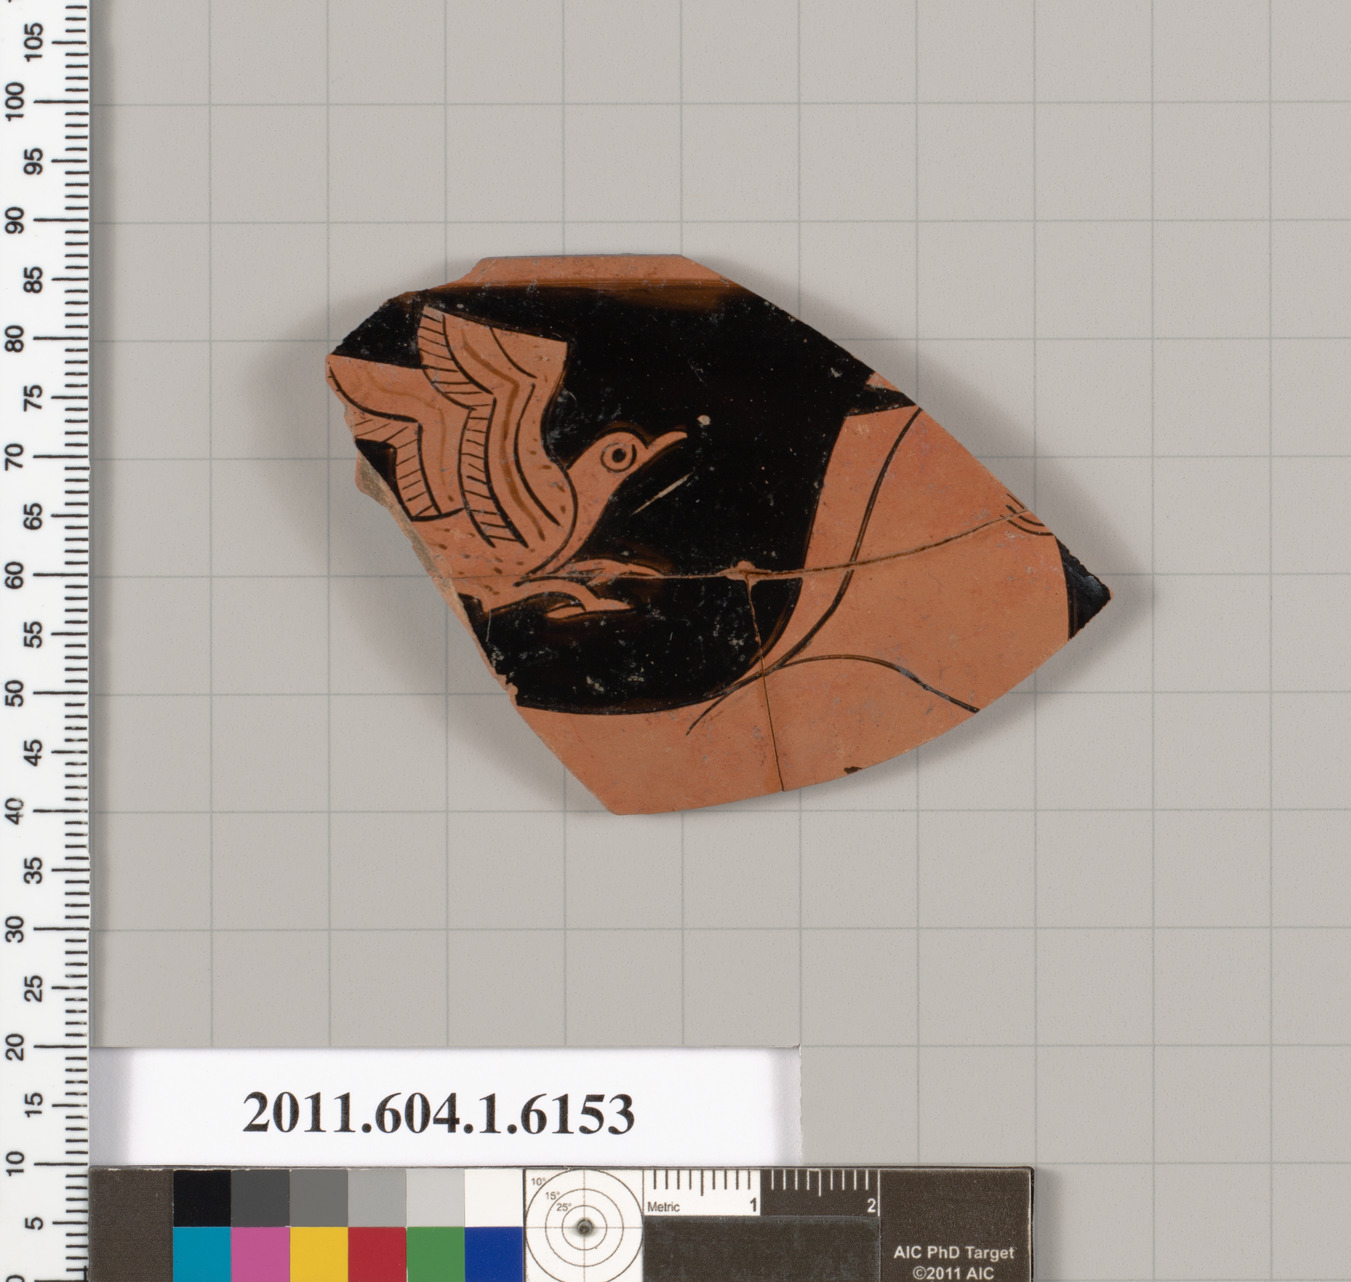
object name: kylix fragment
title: Terracotta rim fragment of a kylix (drinking cup)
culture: greek, attic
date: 520-500 BCE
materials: terracotta